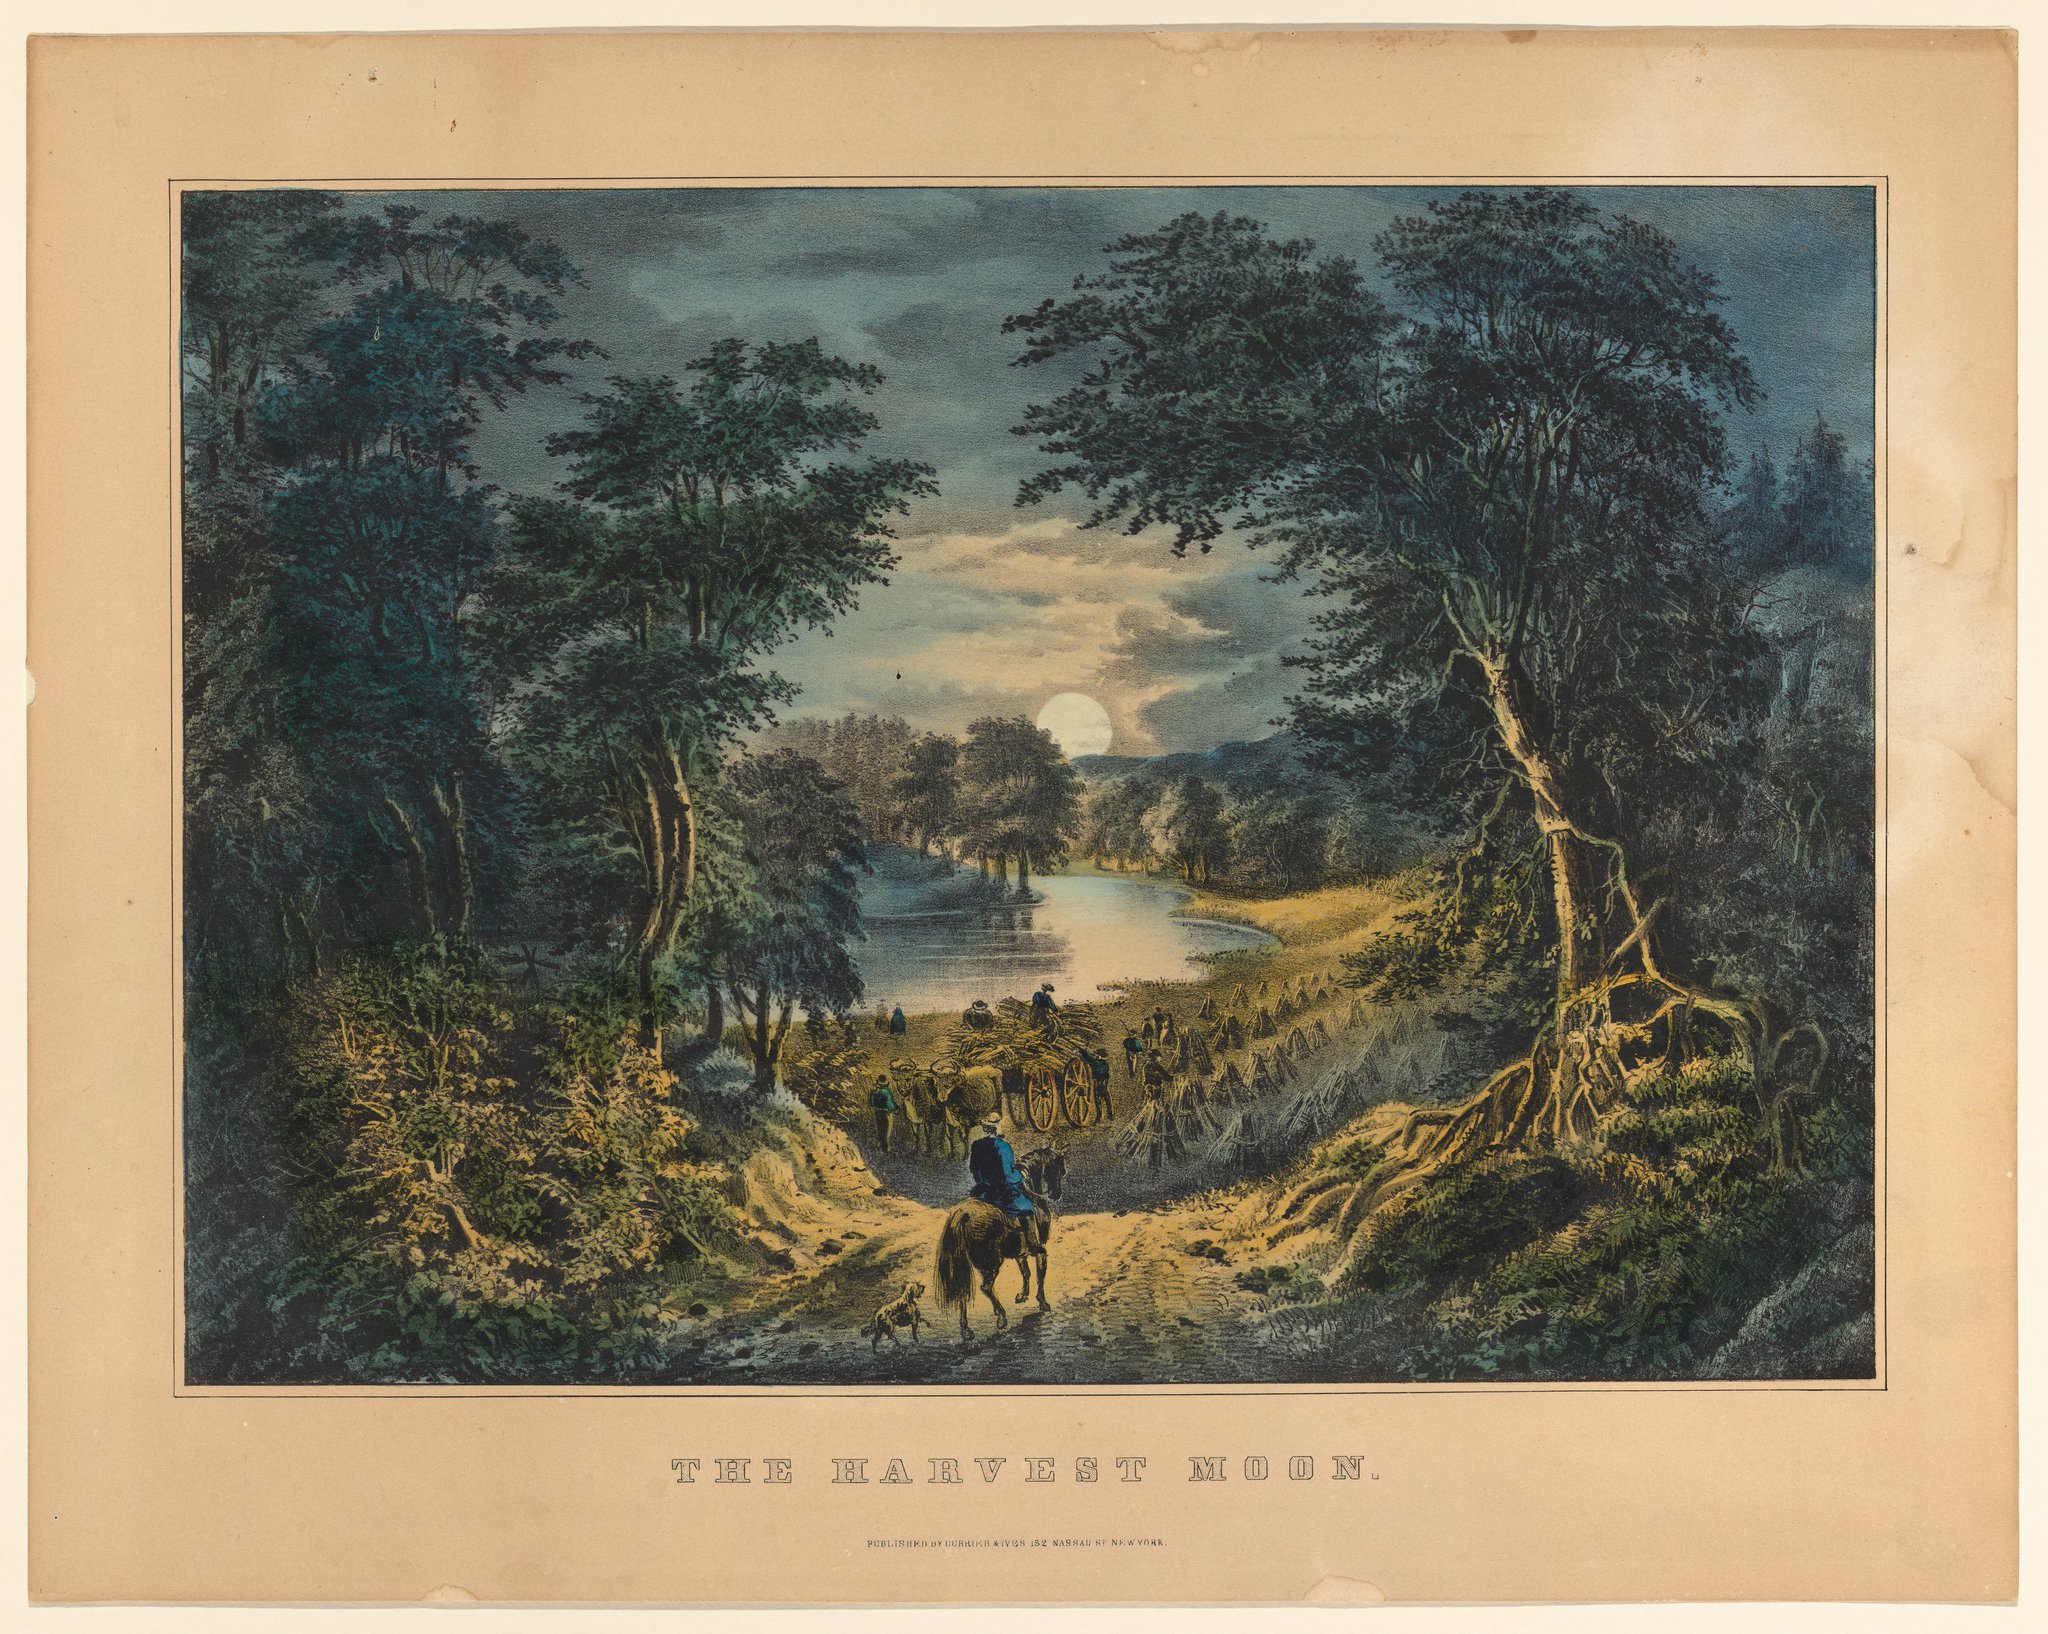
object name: print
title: The Harvest Moon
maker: currier & ives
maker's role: publisher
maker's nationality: american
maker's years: 1857-1907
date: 1857-1871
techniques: hand coloring, lithograph